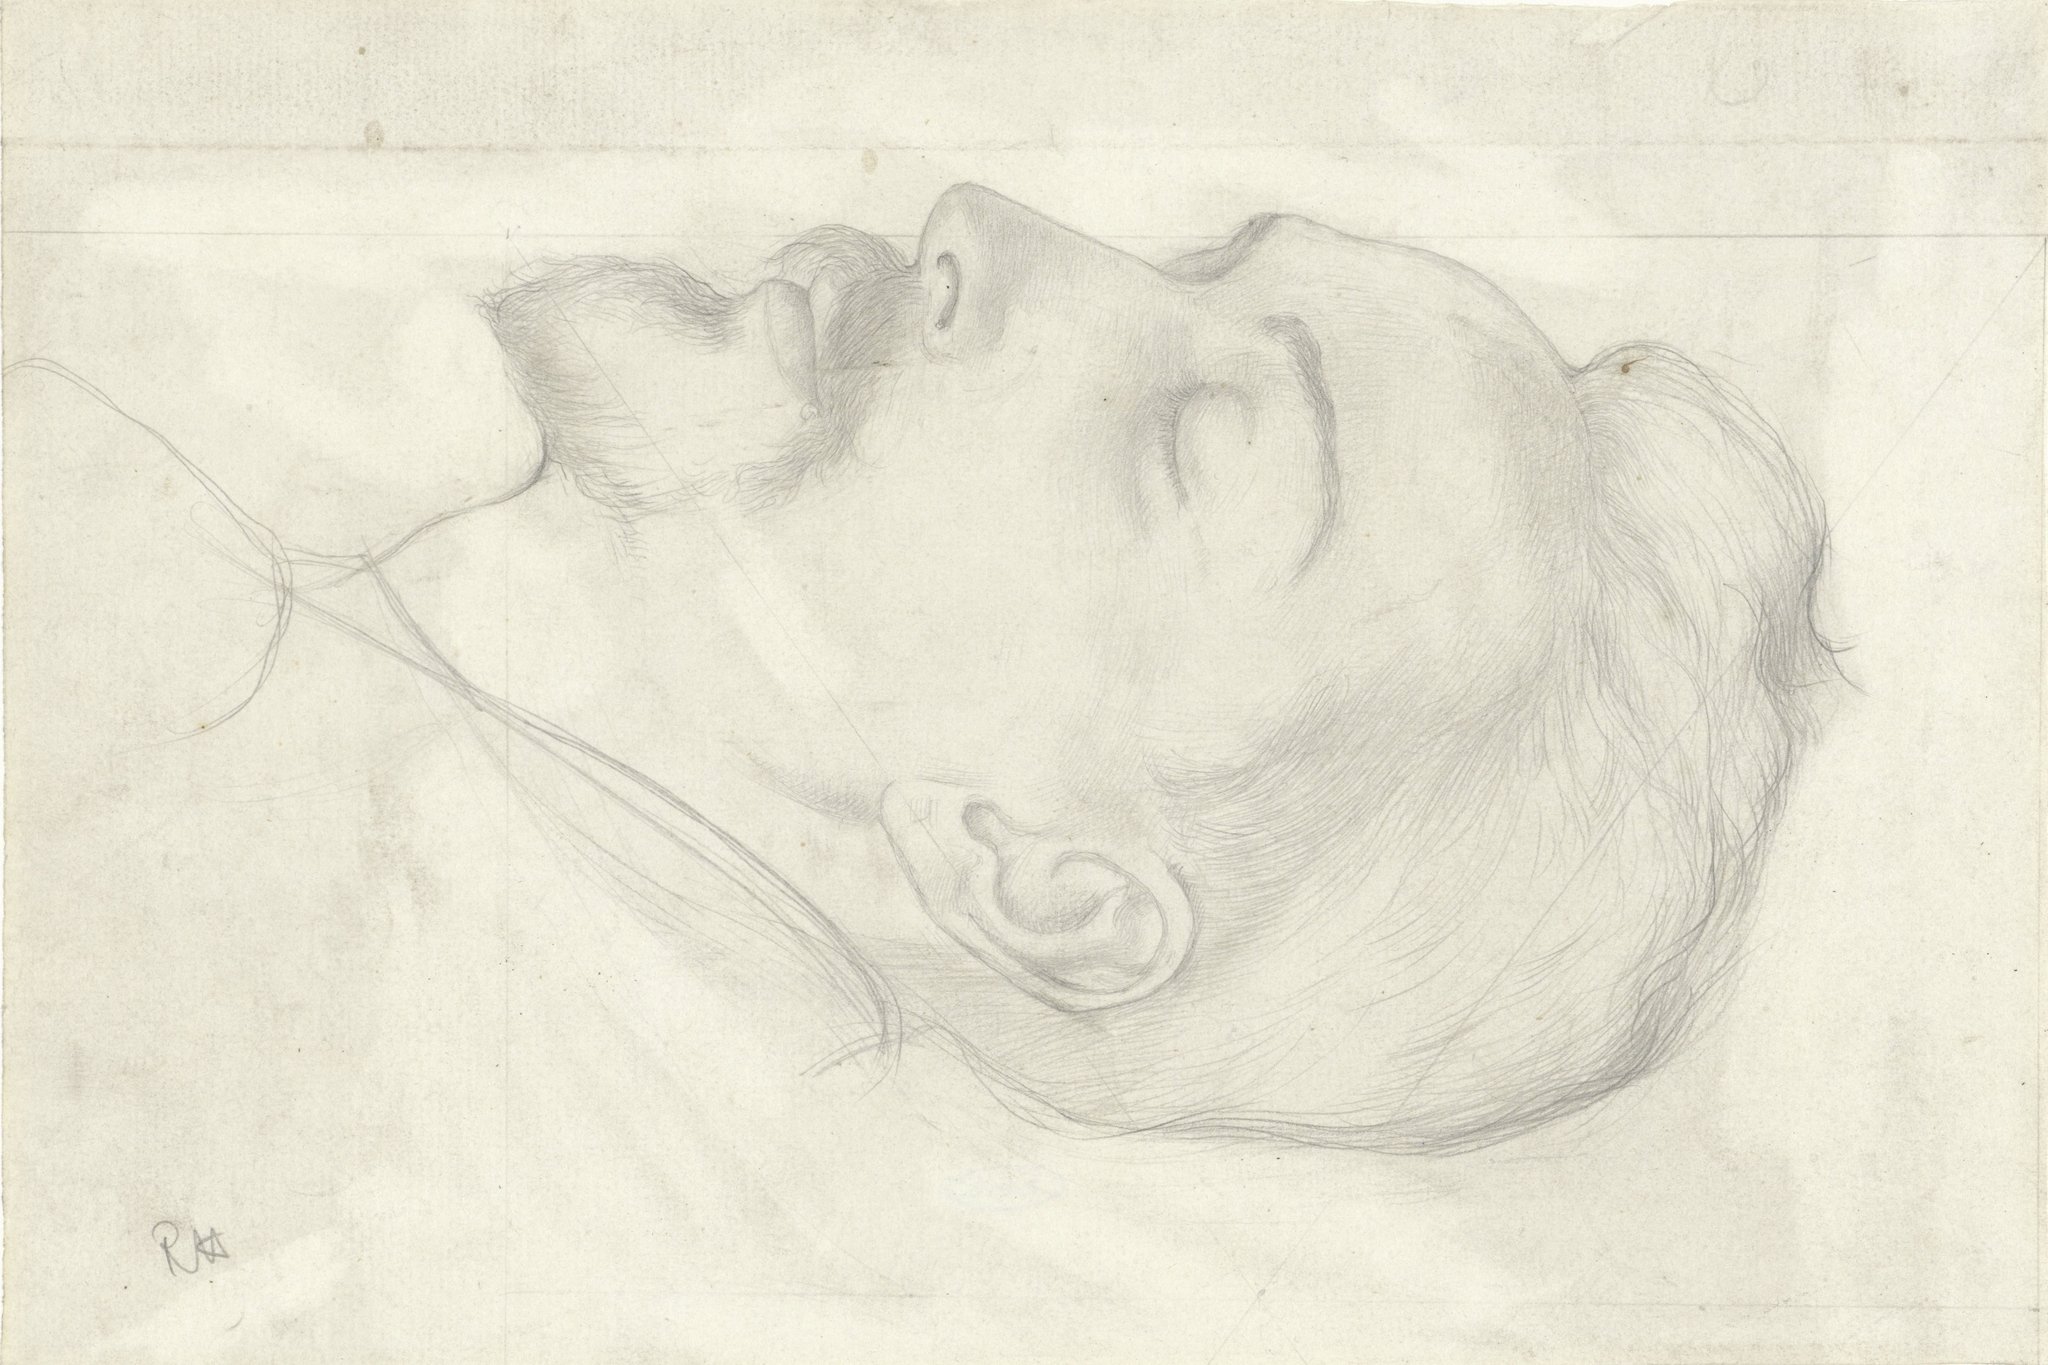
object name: drawing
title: Kop van een slapende man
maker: richard nicolaüs roland holst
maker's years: 1868-1938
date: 1878-1938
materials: paper, pencil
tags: anonymous historical person portrayed alone, sleeping; unconsciousness